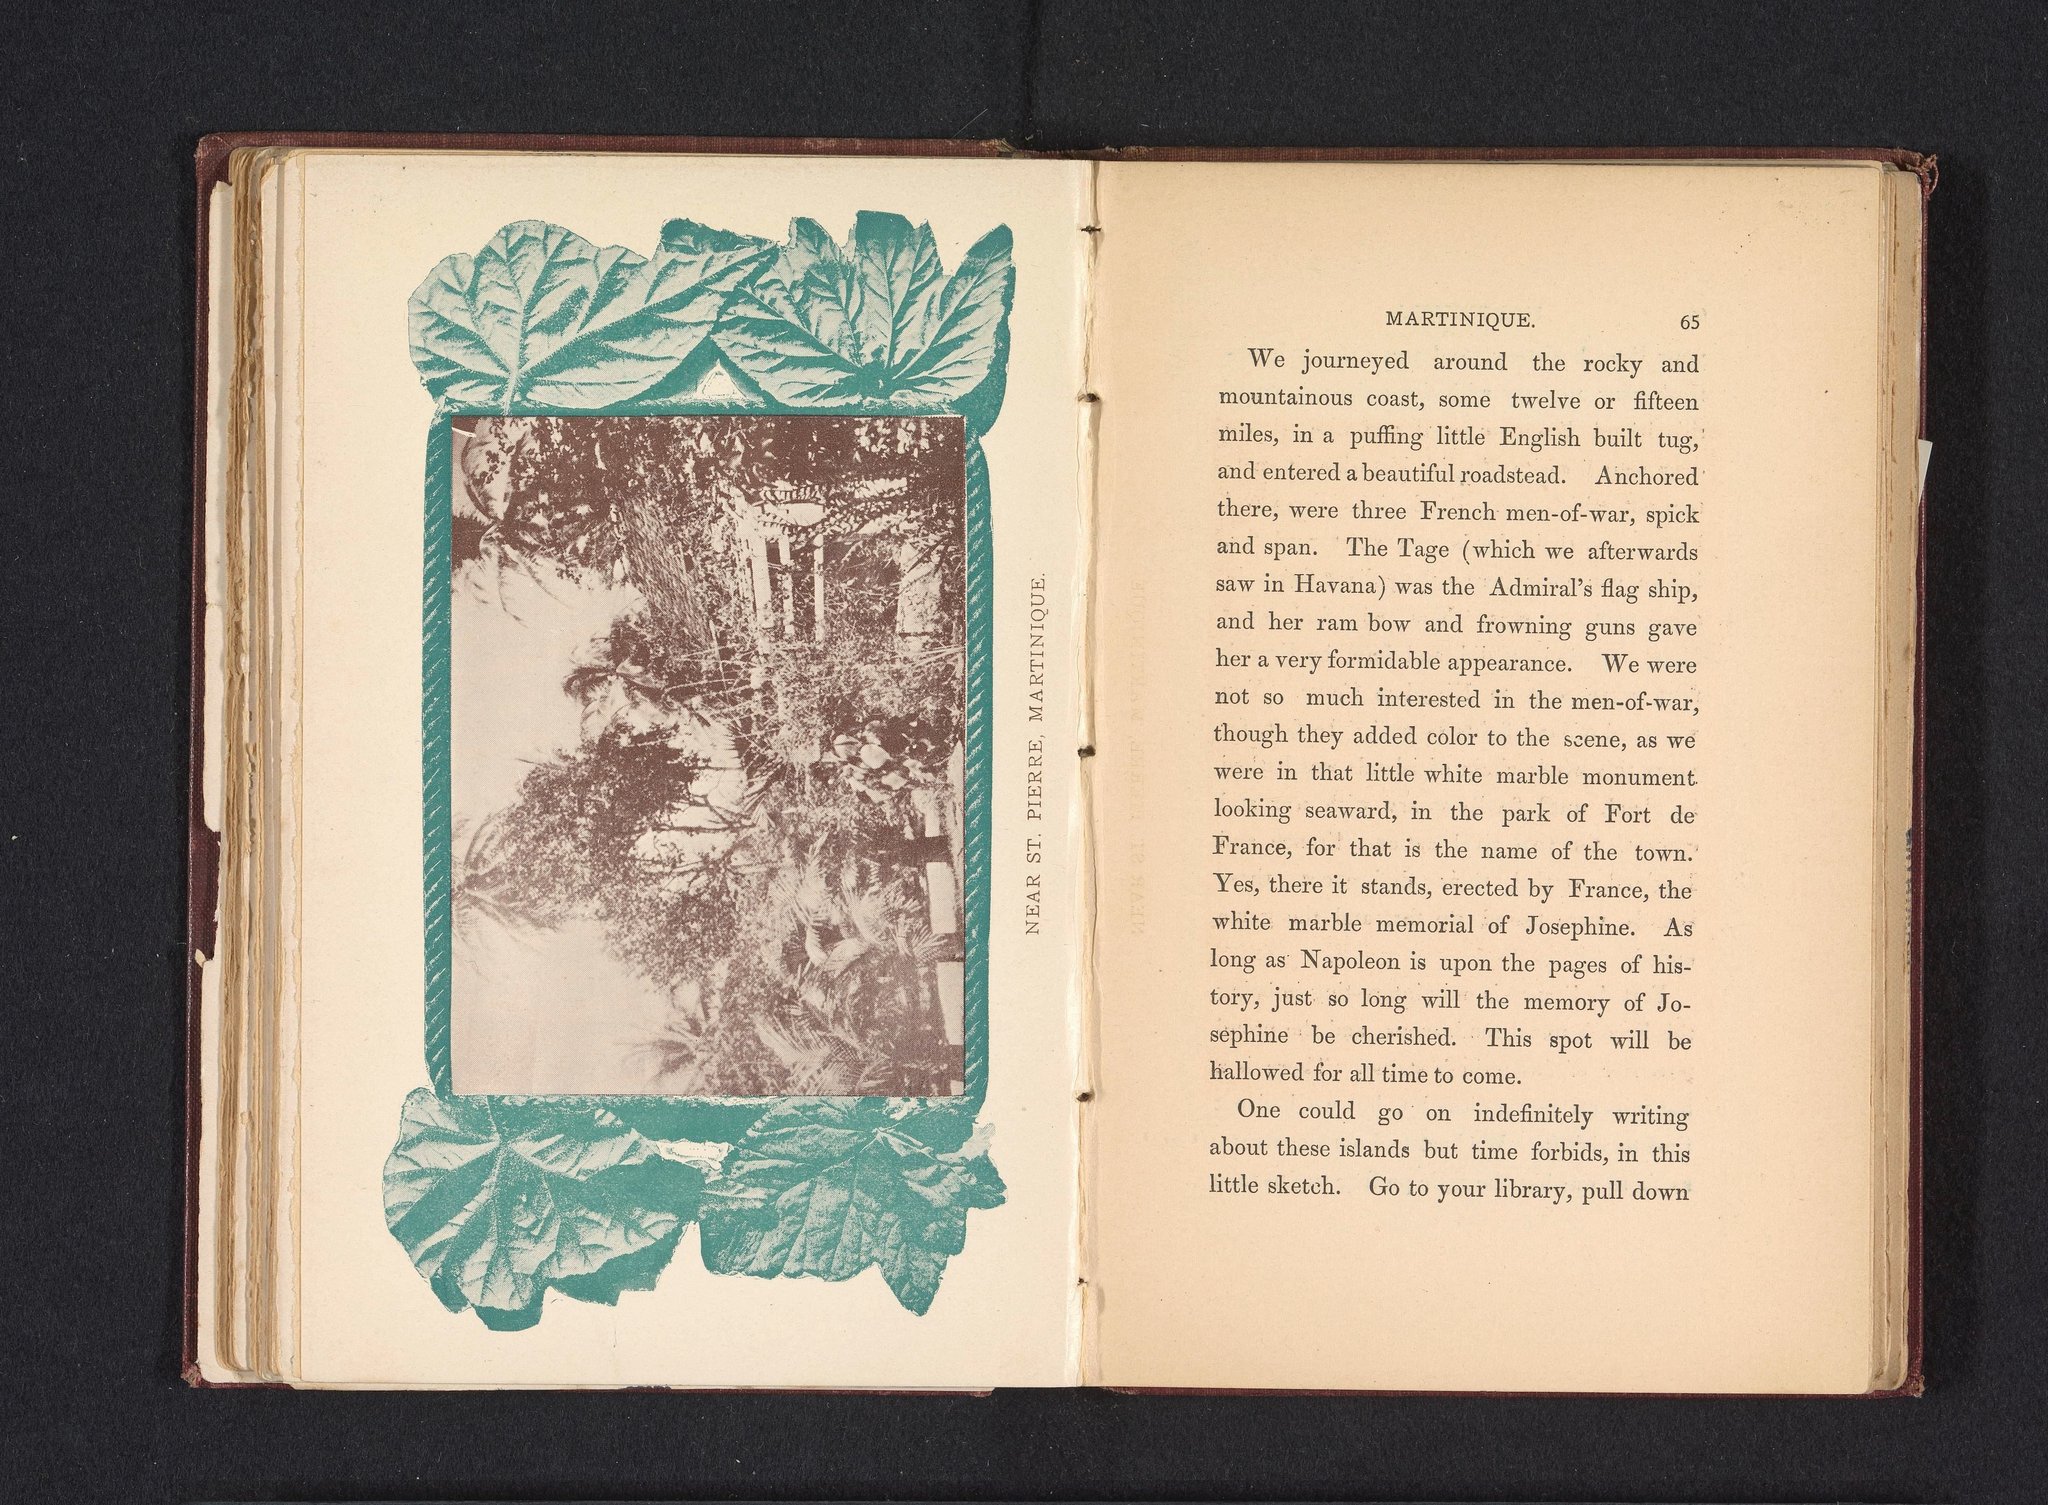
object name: page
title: Near St. Pierre, Martinique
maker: Anonymous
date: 1892-1902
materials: paper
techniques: autotype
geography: martinique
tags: housing, trees: palm-tree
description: Prent in apart gedrukte omlijsting met bladmotief.